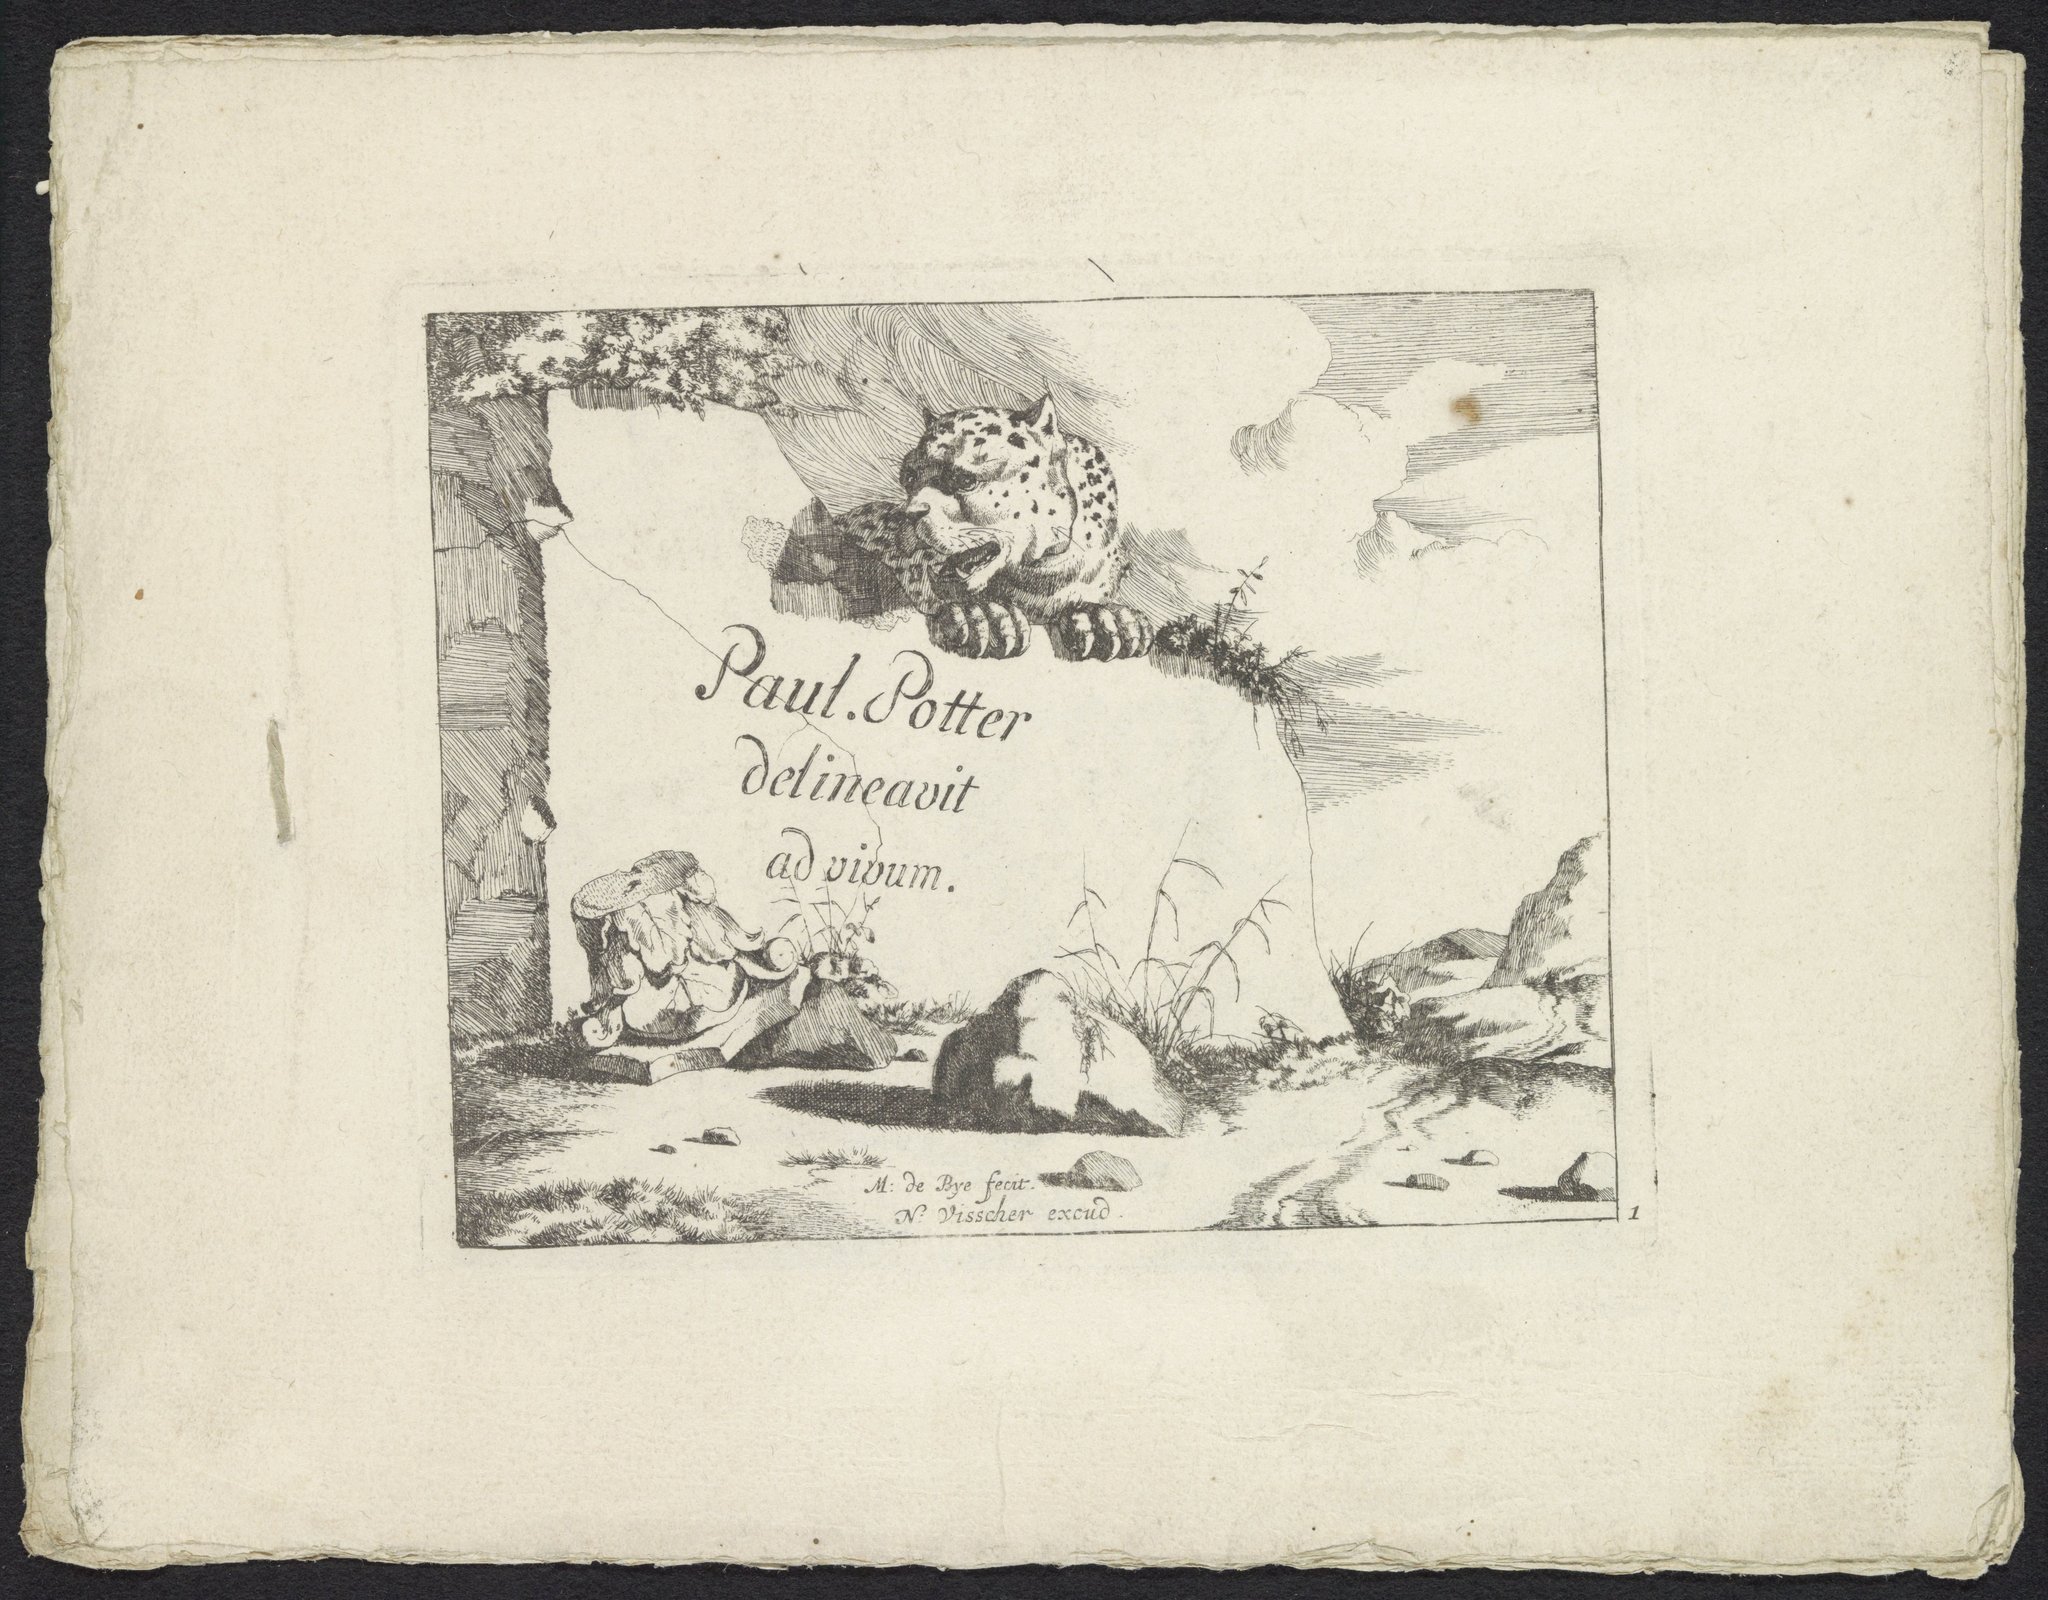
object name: prentrecueil, prentenalbum, prentalbum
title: Serie van acht prenten van luipaarden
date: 1657-1677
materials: paper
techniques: etching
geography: northern netherlands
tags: beasts of prey, predatory animals: leopard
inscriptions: collector's mark: Lugt 2228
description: Serie van acht genummerde prenten met ''naar het leven'' getekende luipaarden, de reeks met een touwtje bijeen gebonden.